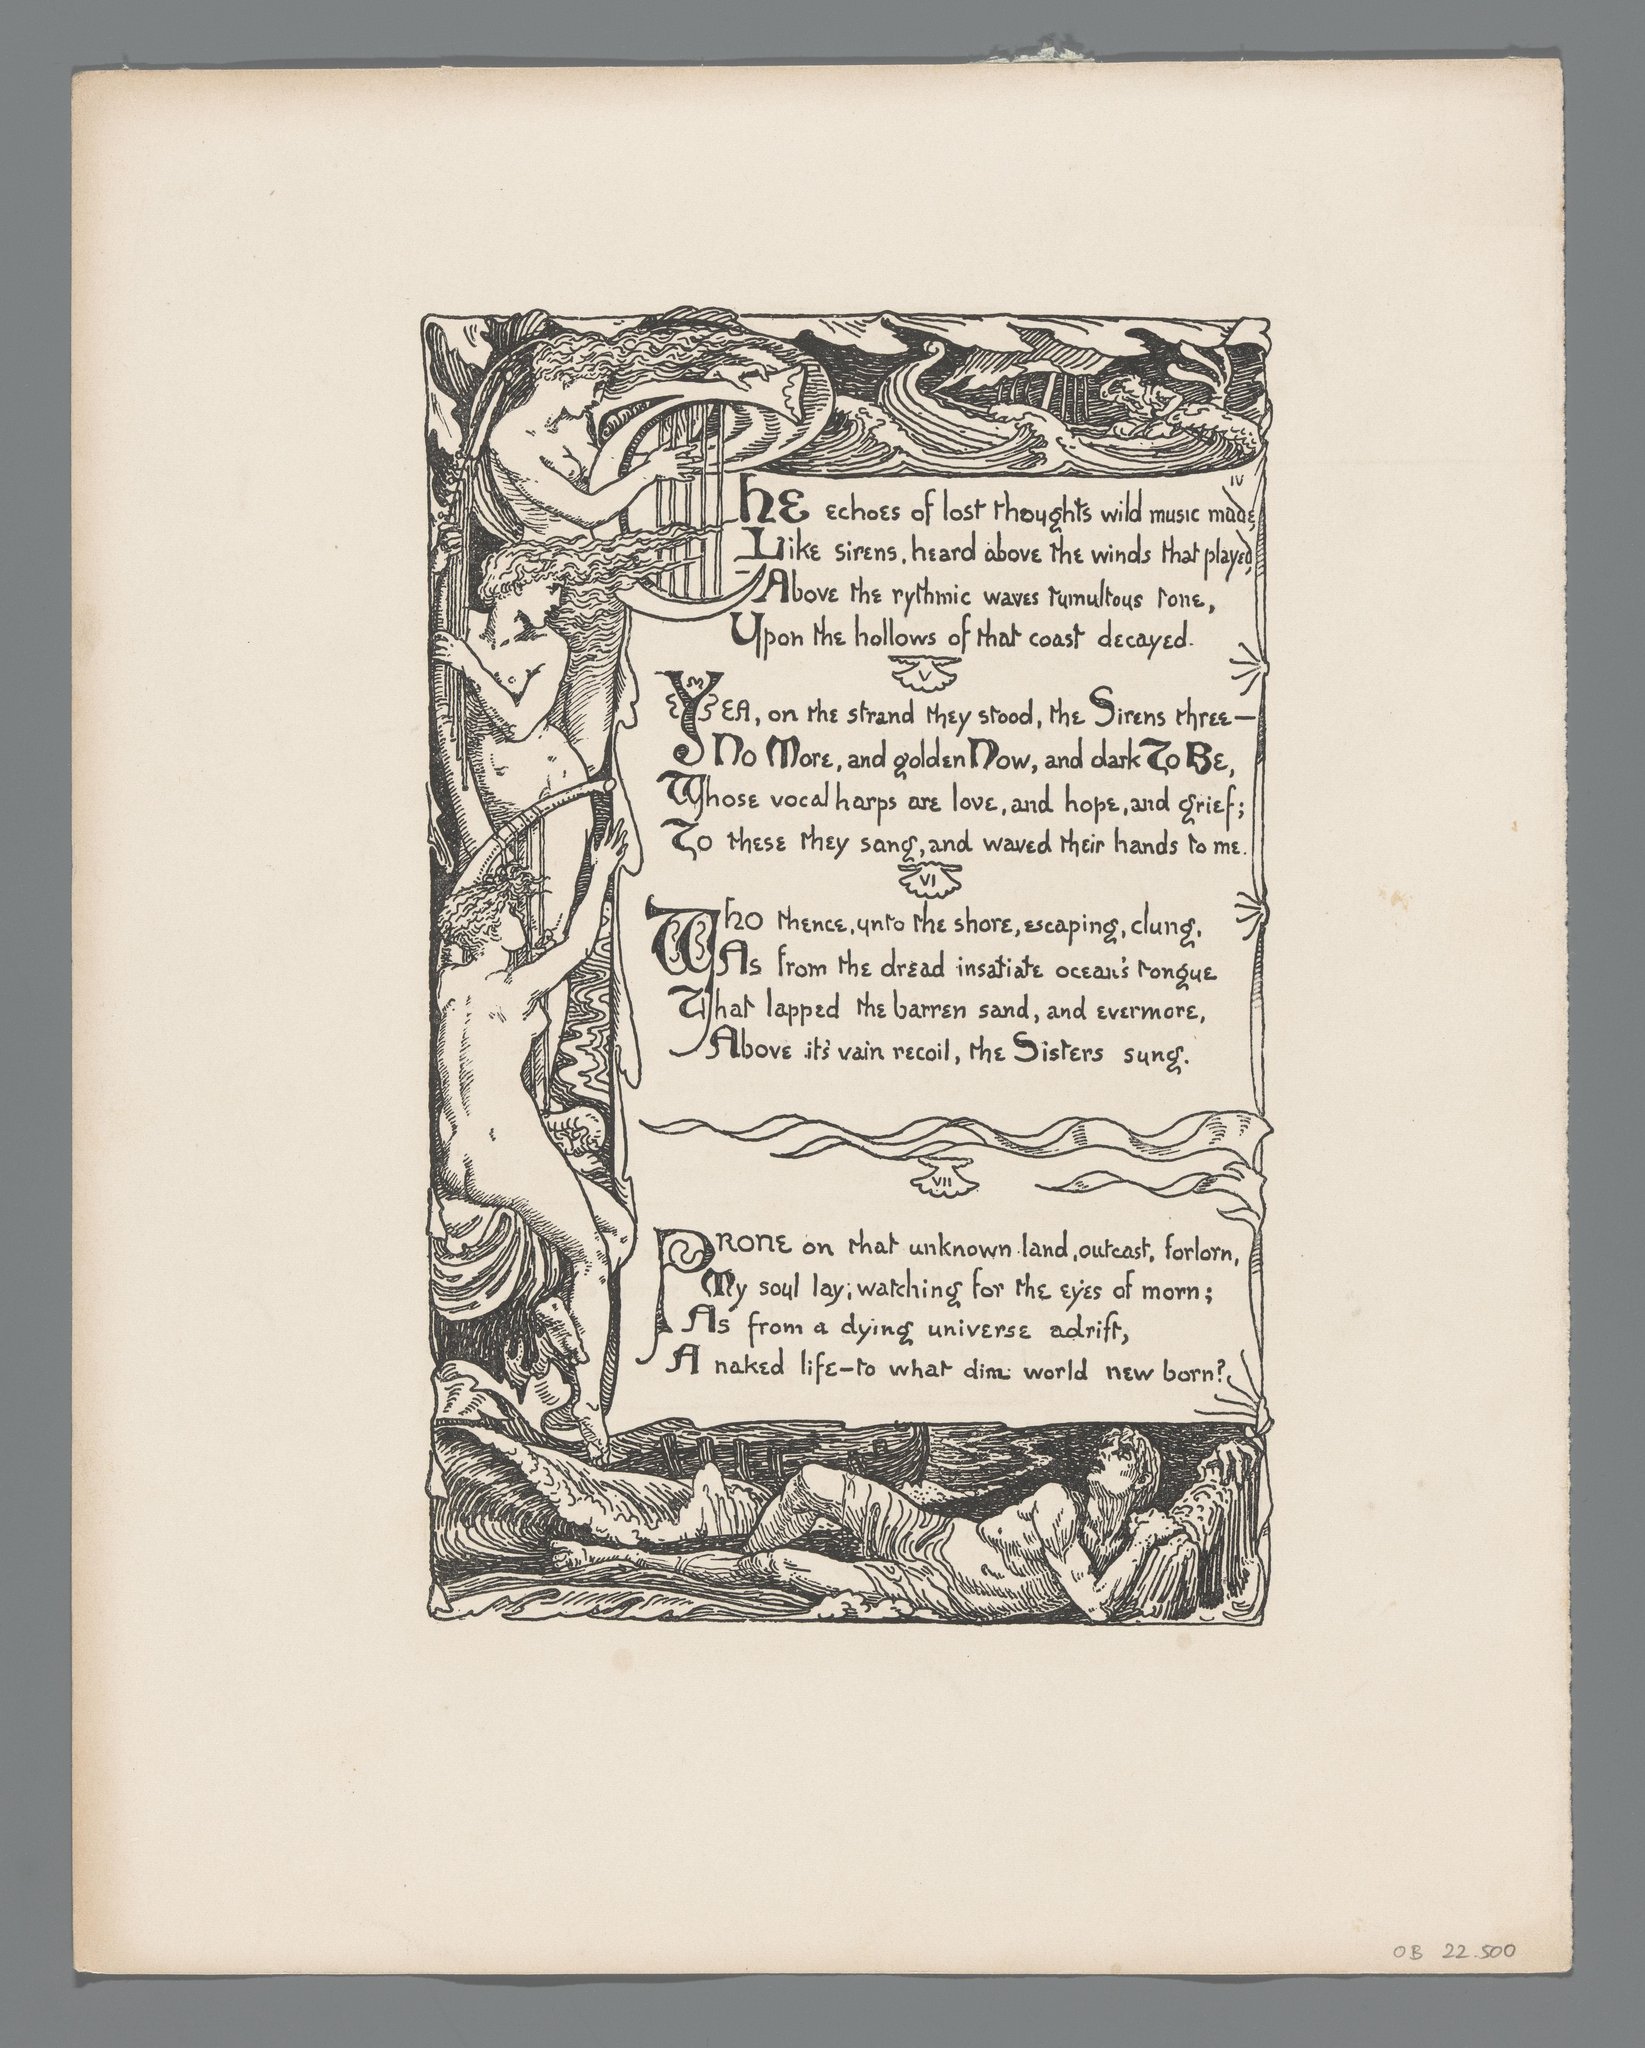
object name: book illustration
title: Cartouche met sirenen en een drenkeling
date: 1886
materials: paper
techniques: engraving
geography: london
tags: musical instruments; group of musical instruments, merman - aa - mermaid, siren, drowning, shipwrecked person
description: Prent uit: Crane, Walter. The sirens three. Londen: Macmillan & Co., 1886.